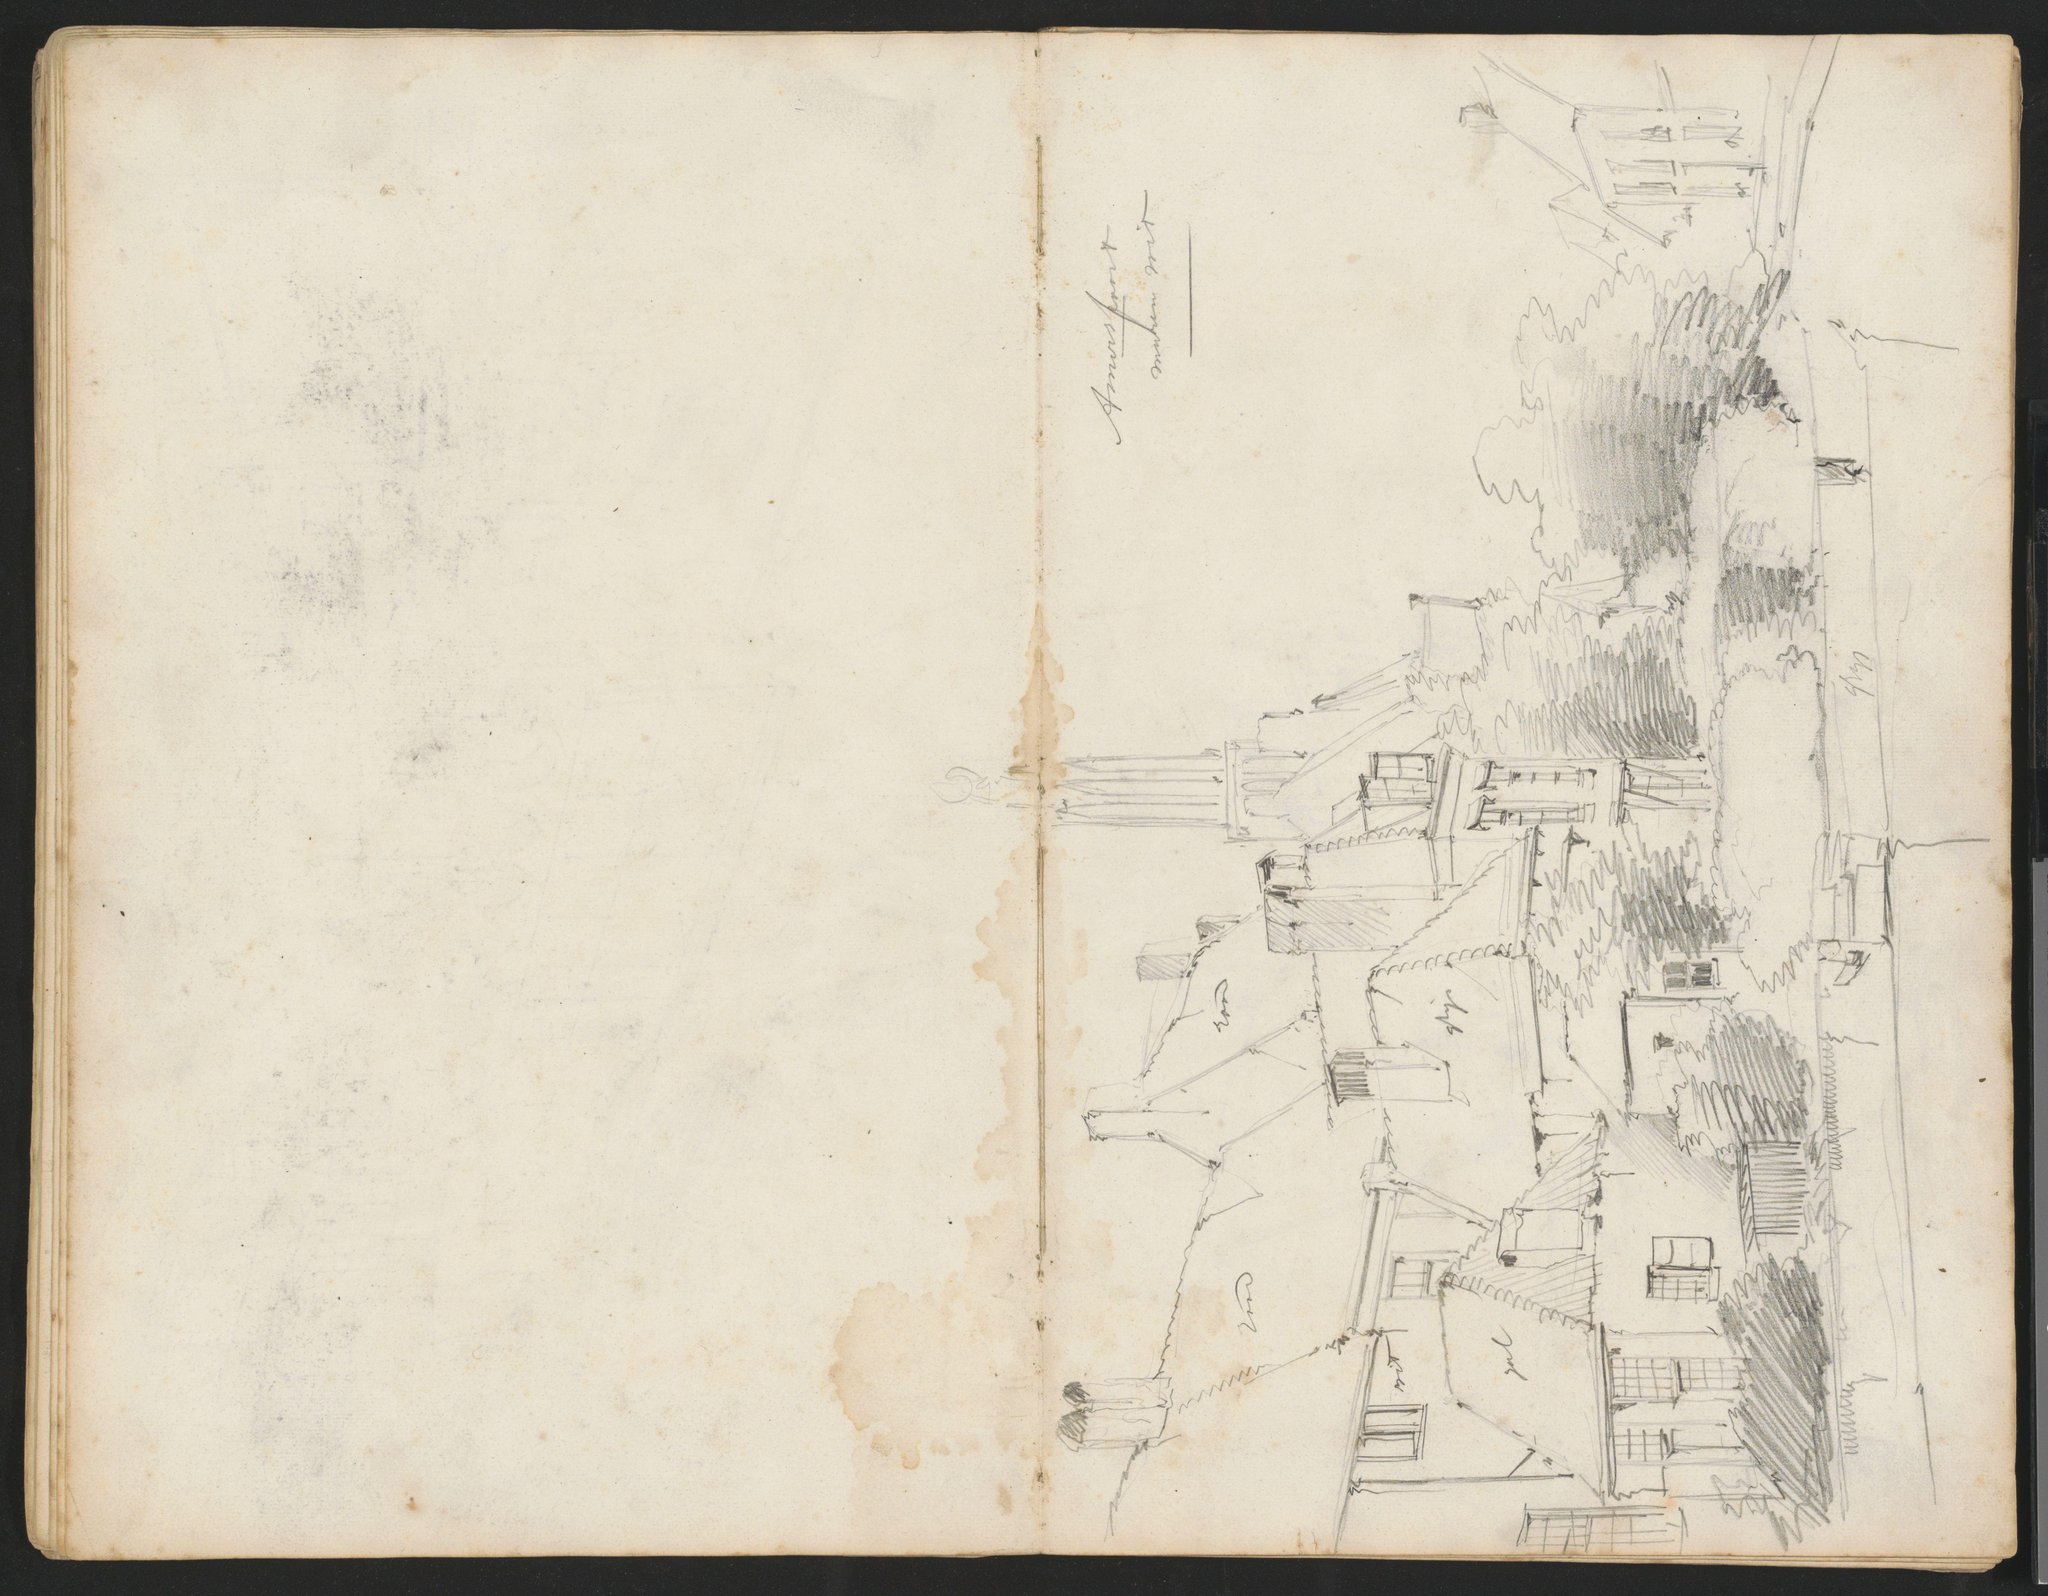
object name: sketchbook leaf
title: Onze-Lieve-Vrouwetoren gezien vanaf de Westsingel te Amersfoort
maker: willem koekkoek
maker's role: draughtsman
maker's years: 1839-1895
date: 1849-1895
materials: paper, pencil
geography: amersfoort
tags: city-view, and landscape with man-made constructions, parts of church exterior and annexes: tower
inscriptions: annotation: ‘Amersfoort’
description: Blad 11 verso en 12 recto uit een schetsboek met 42 bladen.